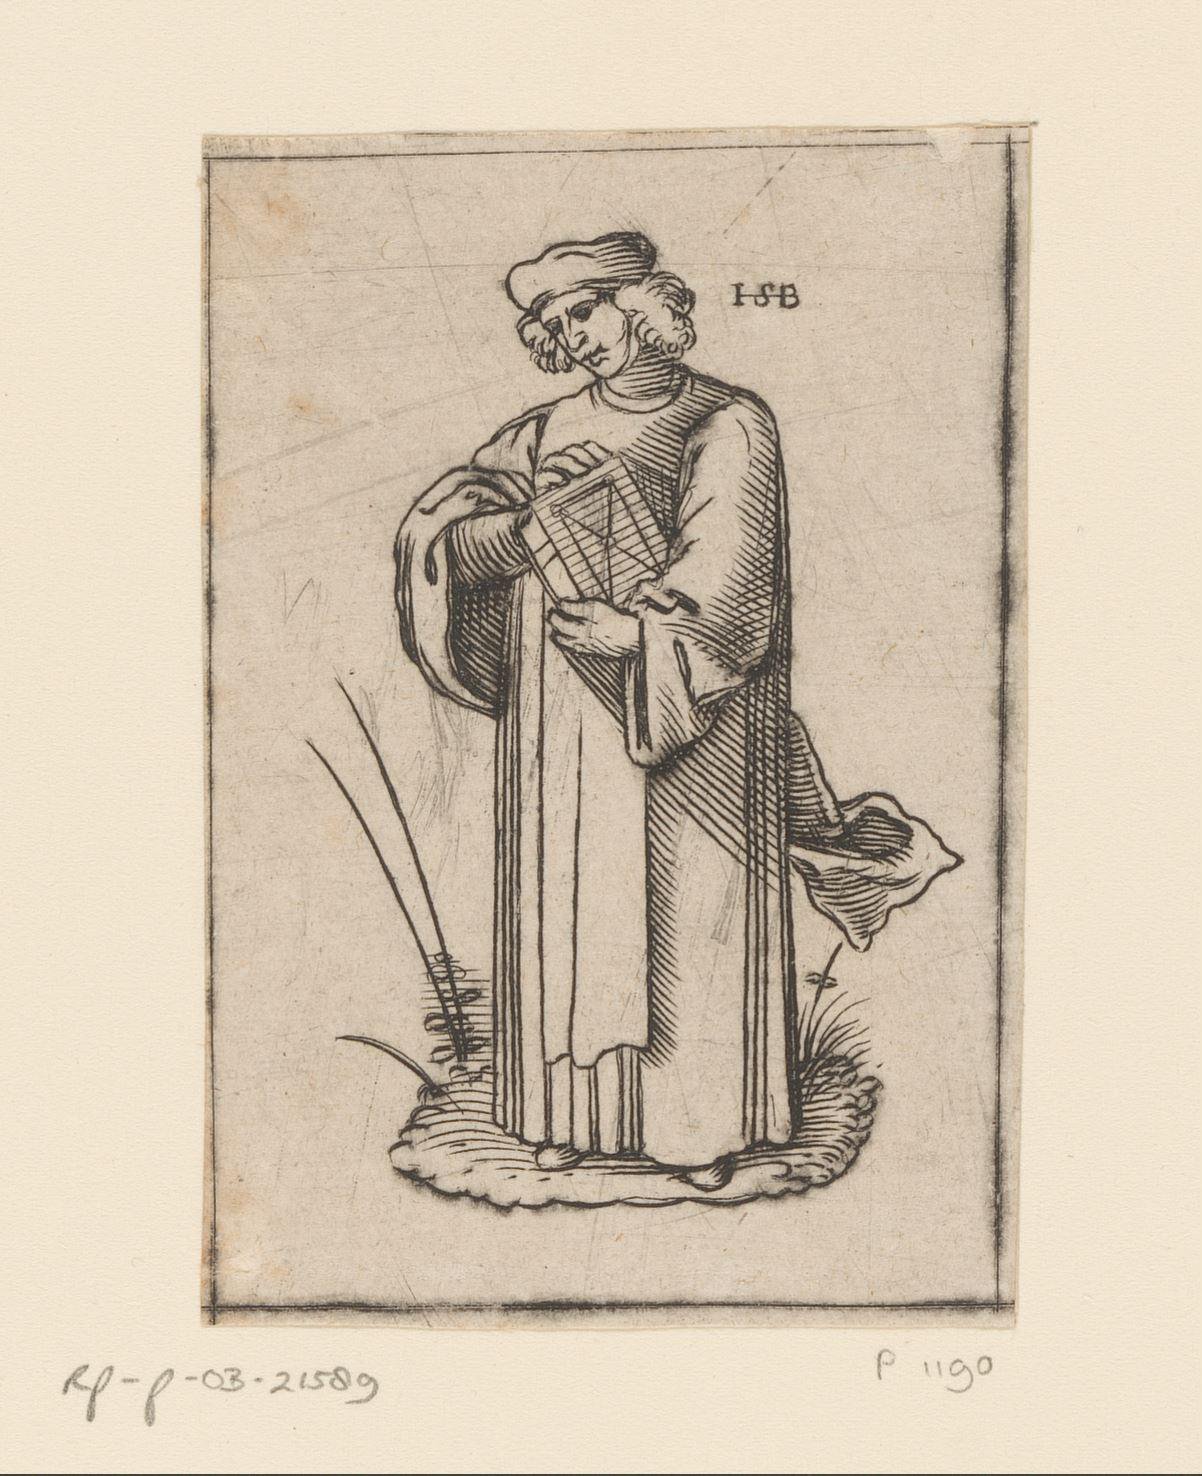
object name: print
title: Kostuums van geestelijken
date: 1526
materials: paper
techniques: engraving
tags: liturgical vestments, canonicals, monastic orders, monastic life ~ roman catholic church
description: Onderdeel van een serie van 28 gegraveerde kopieën in de andere richting naar Hans Sebald Behams "Das Papstthum mit seinen Gliedern", 1526.